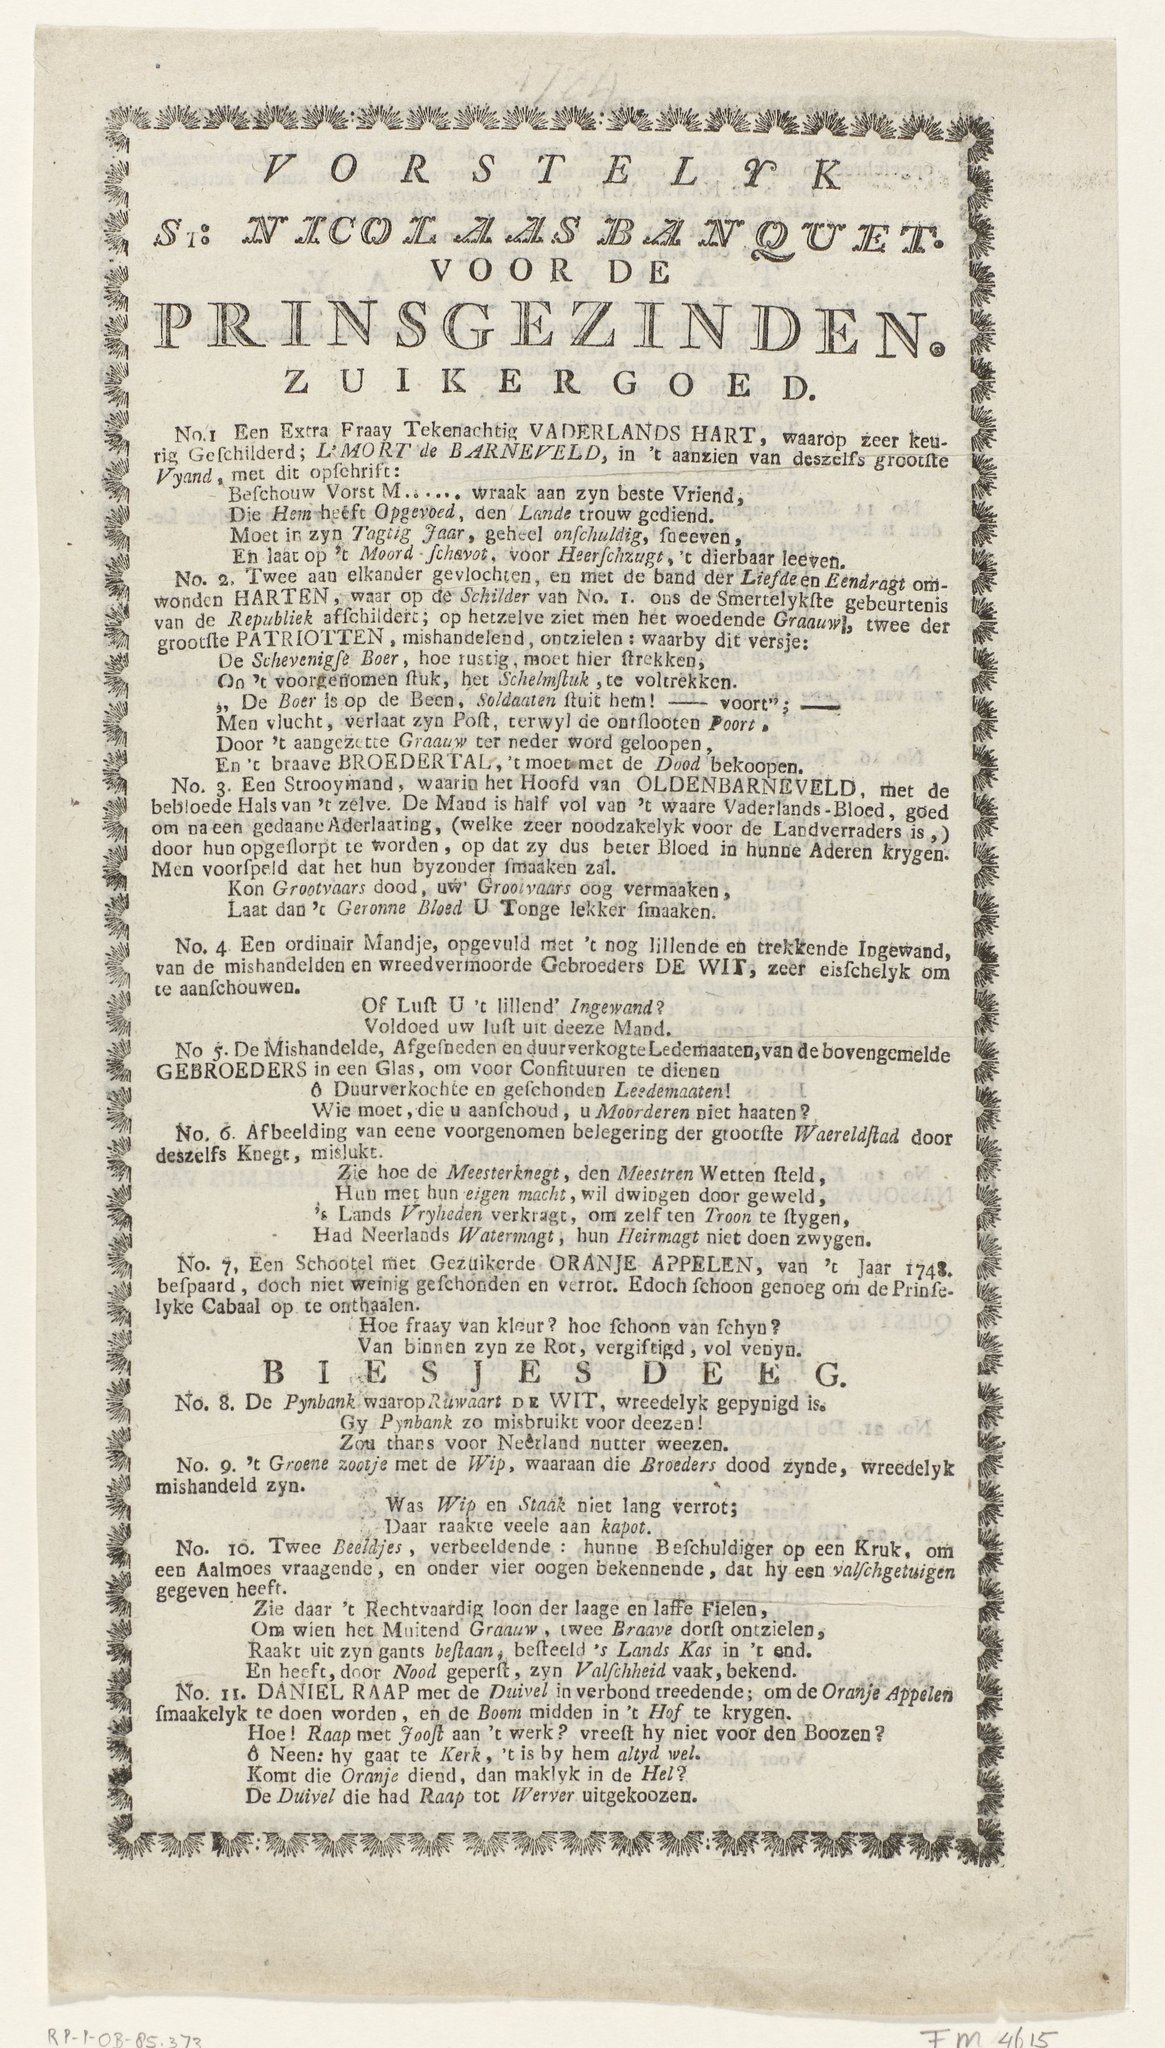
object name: text sheet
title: Vorstelyk St: Nicolaas Banquet. voor de Prinsgezinden. Zuikergoed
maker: Anonymous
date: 1784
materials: paper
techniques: letterpress printing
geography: northern netherlands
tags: johan van oldenbarnevelt, dordrecht, the hague, cornelis de witt, politician, johan de witt, patriots (1780-1795)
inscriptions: collector's mark: Lugt 2228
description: Tekstblad met op beide zijden een patriots spotvers in 23 refreinen met recepten voor prinsgezinde koeken en suikergoed. Met verwijzingen naar de terechtstelling van Johan van Oldenbarnevelt en de moord op de gebroeders de Witt.